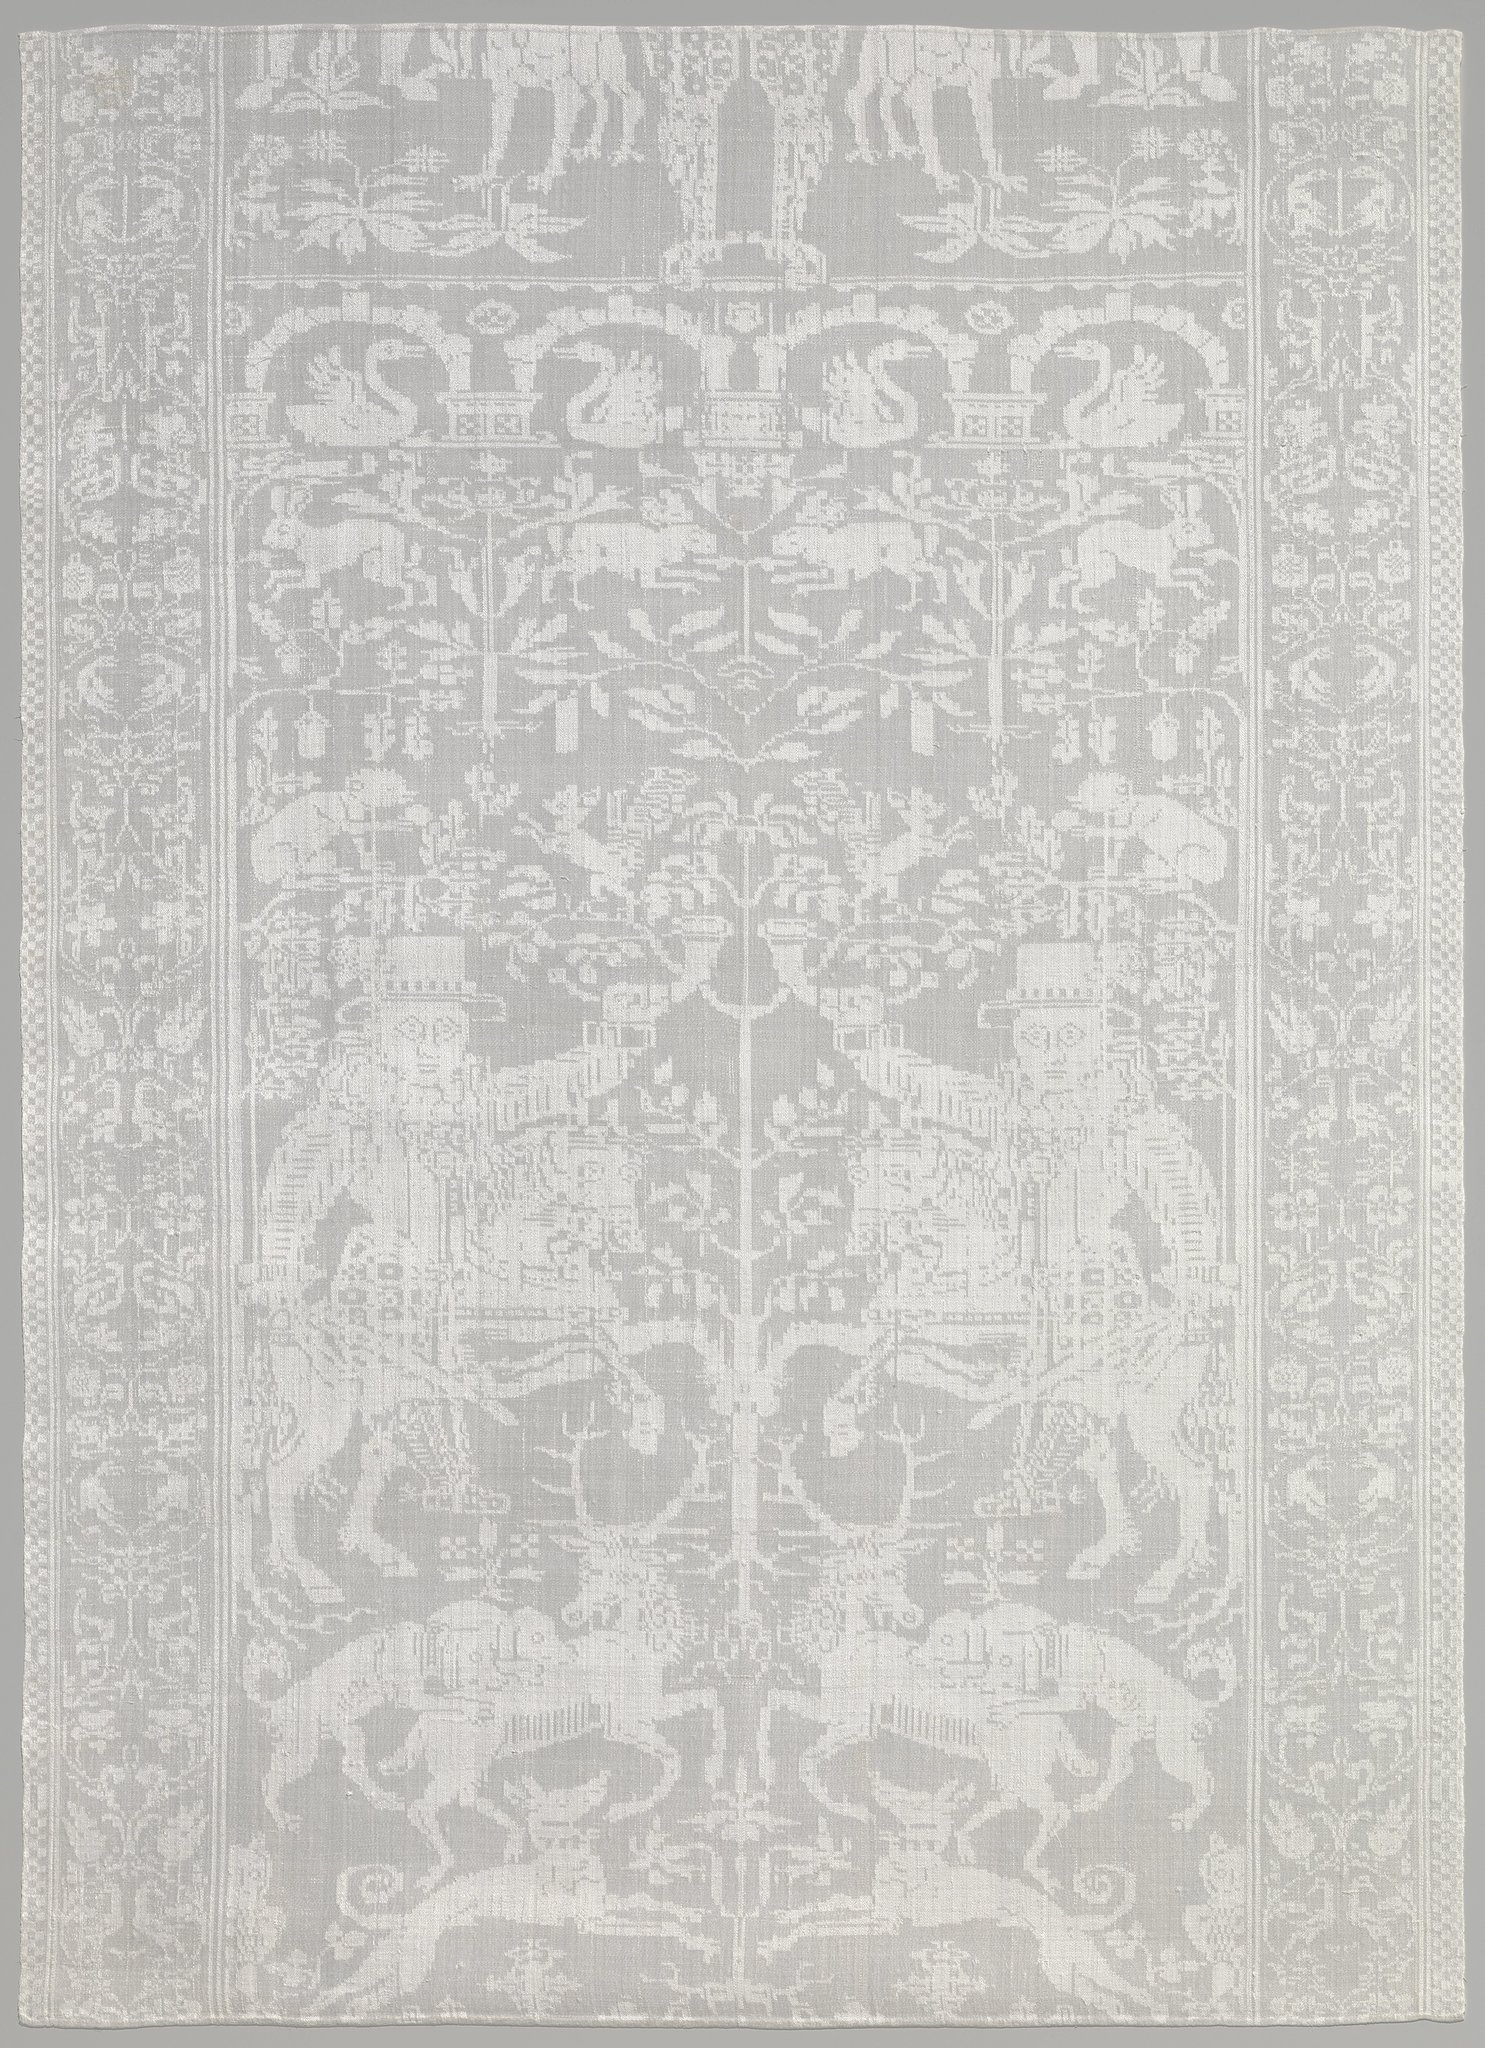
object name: napkin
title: servet met zwanen onder brug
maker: Anonymous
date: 1610-1630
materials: linen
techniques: damask, weave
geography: haarlem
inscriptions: mark: ‘Kroon/ HW/ 23’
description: Wit linnen damasten servet met een jacht en zwanen onder brug. Merk Kroon HW 23